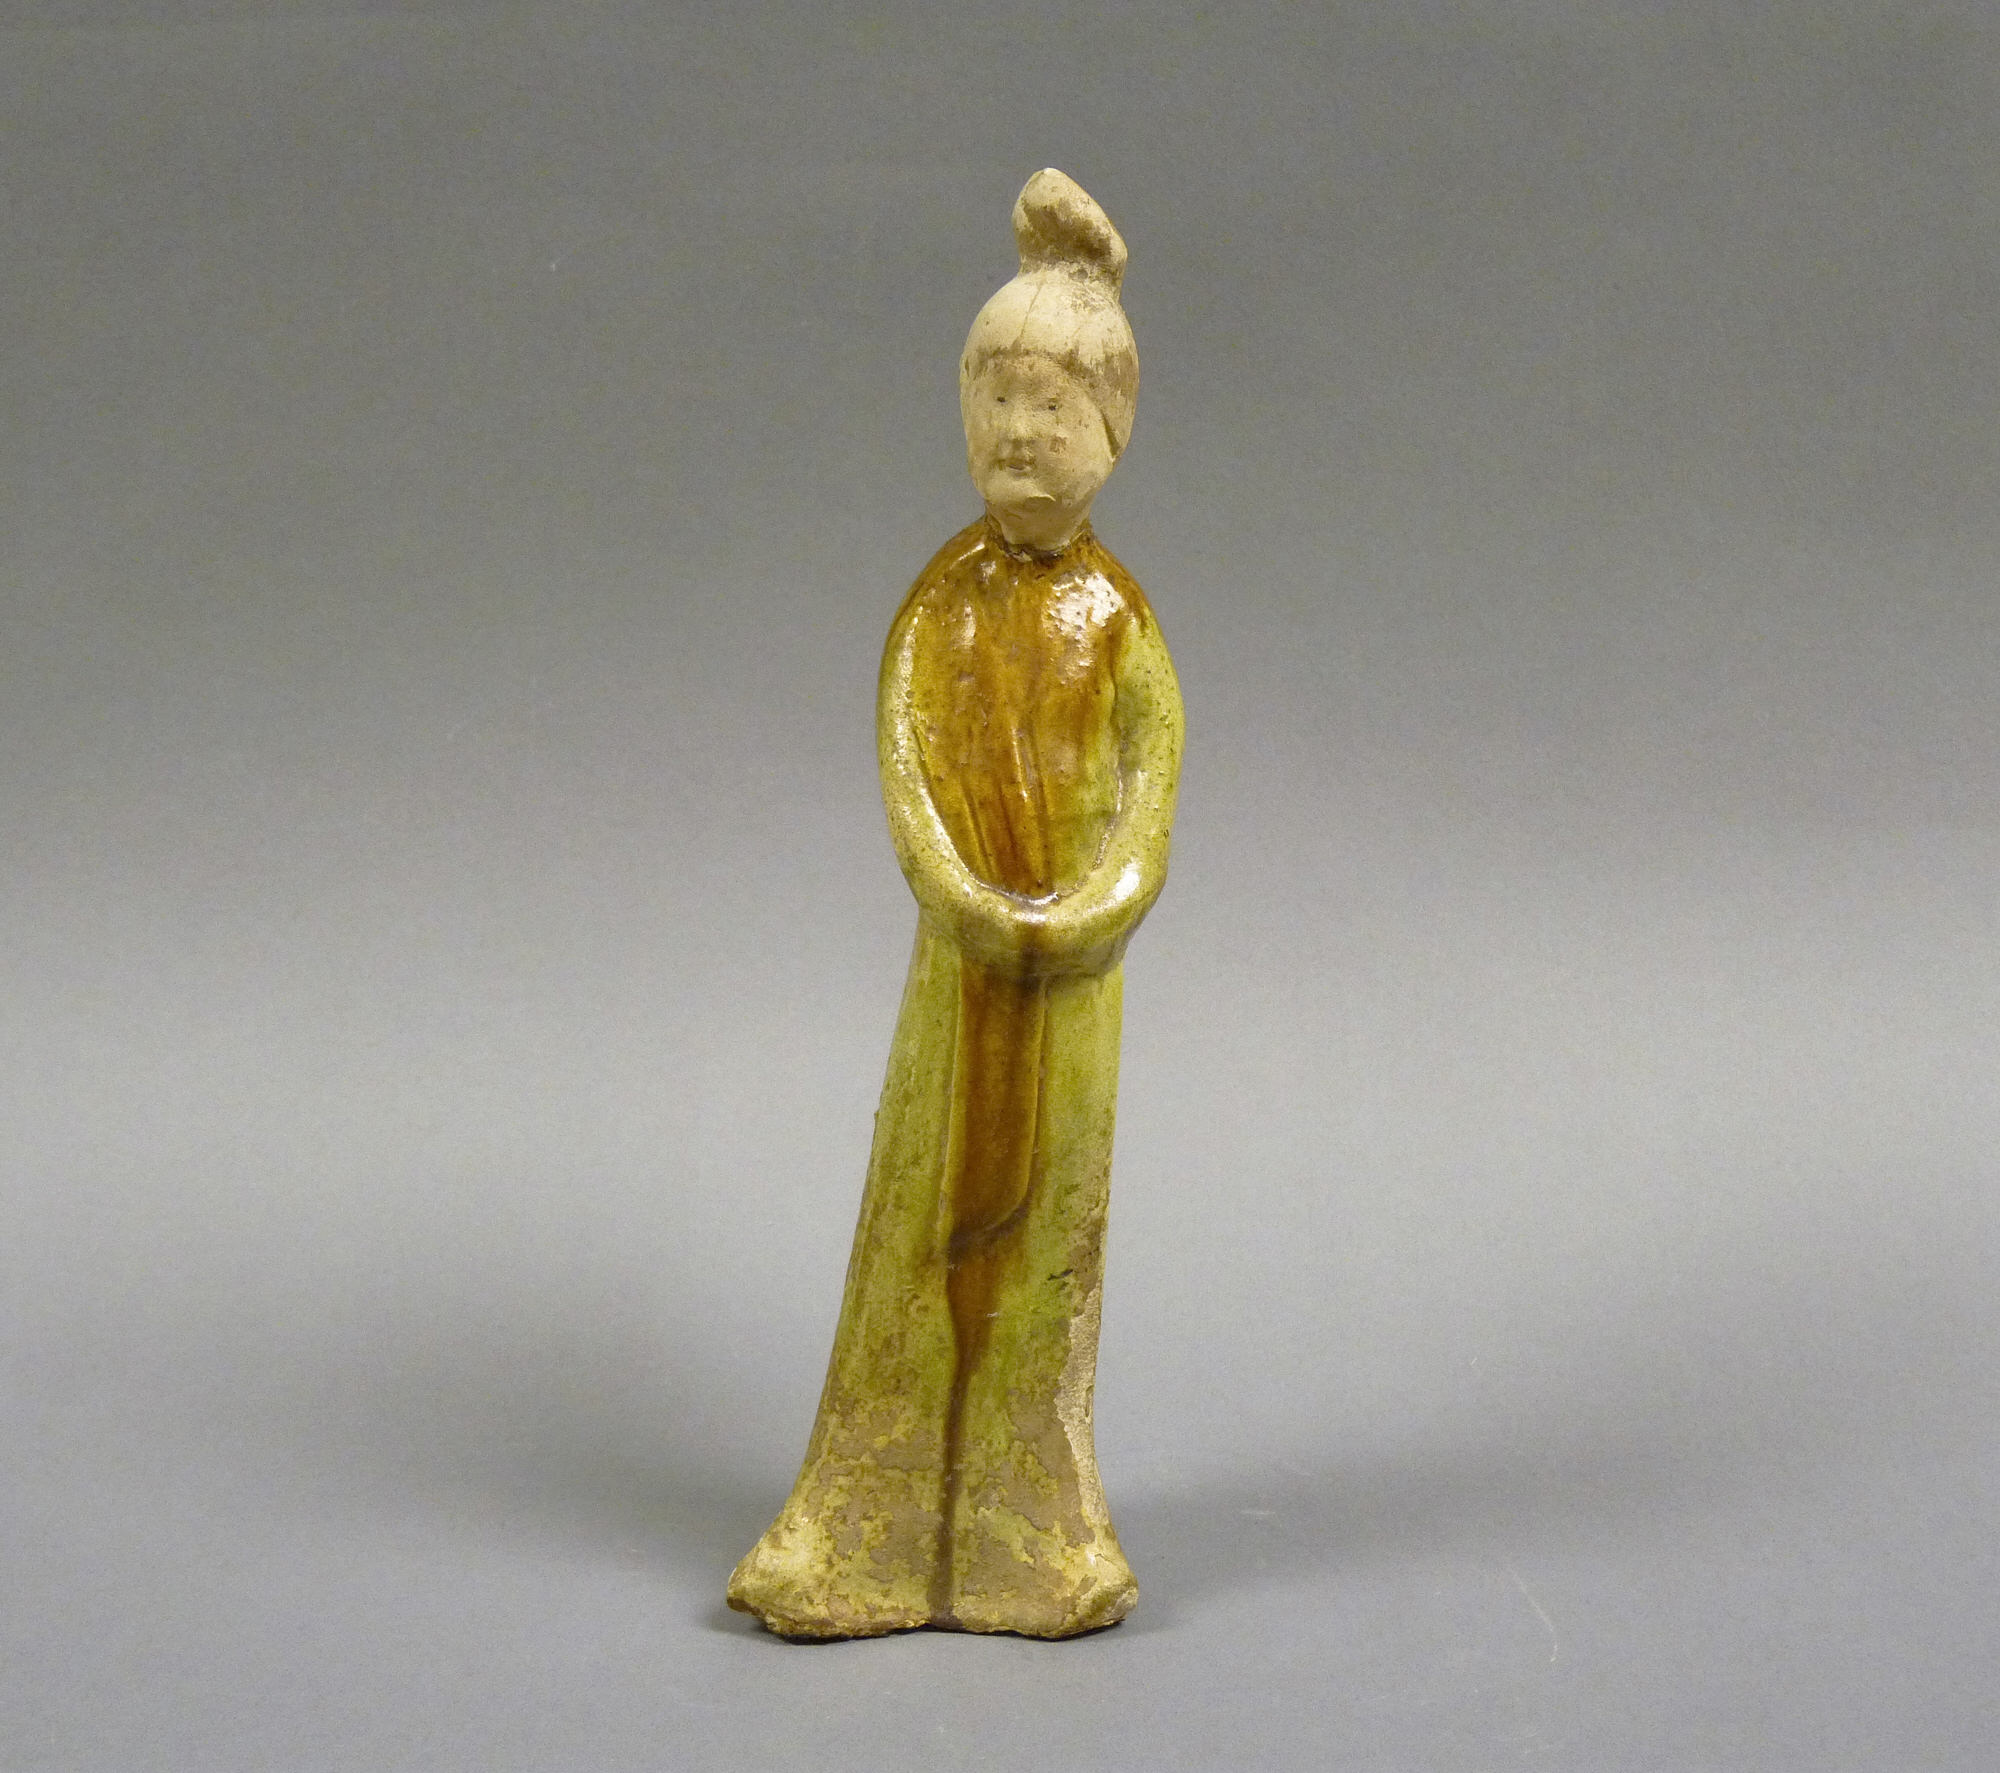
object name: figure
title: Figure of a standing woman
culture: chinese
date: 601-800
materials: glaze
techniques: polychrome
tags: women